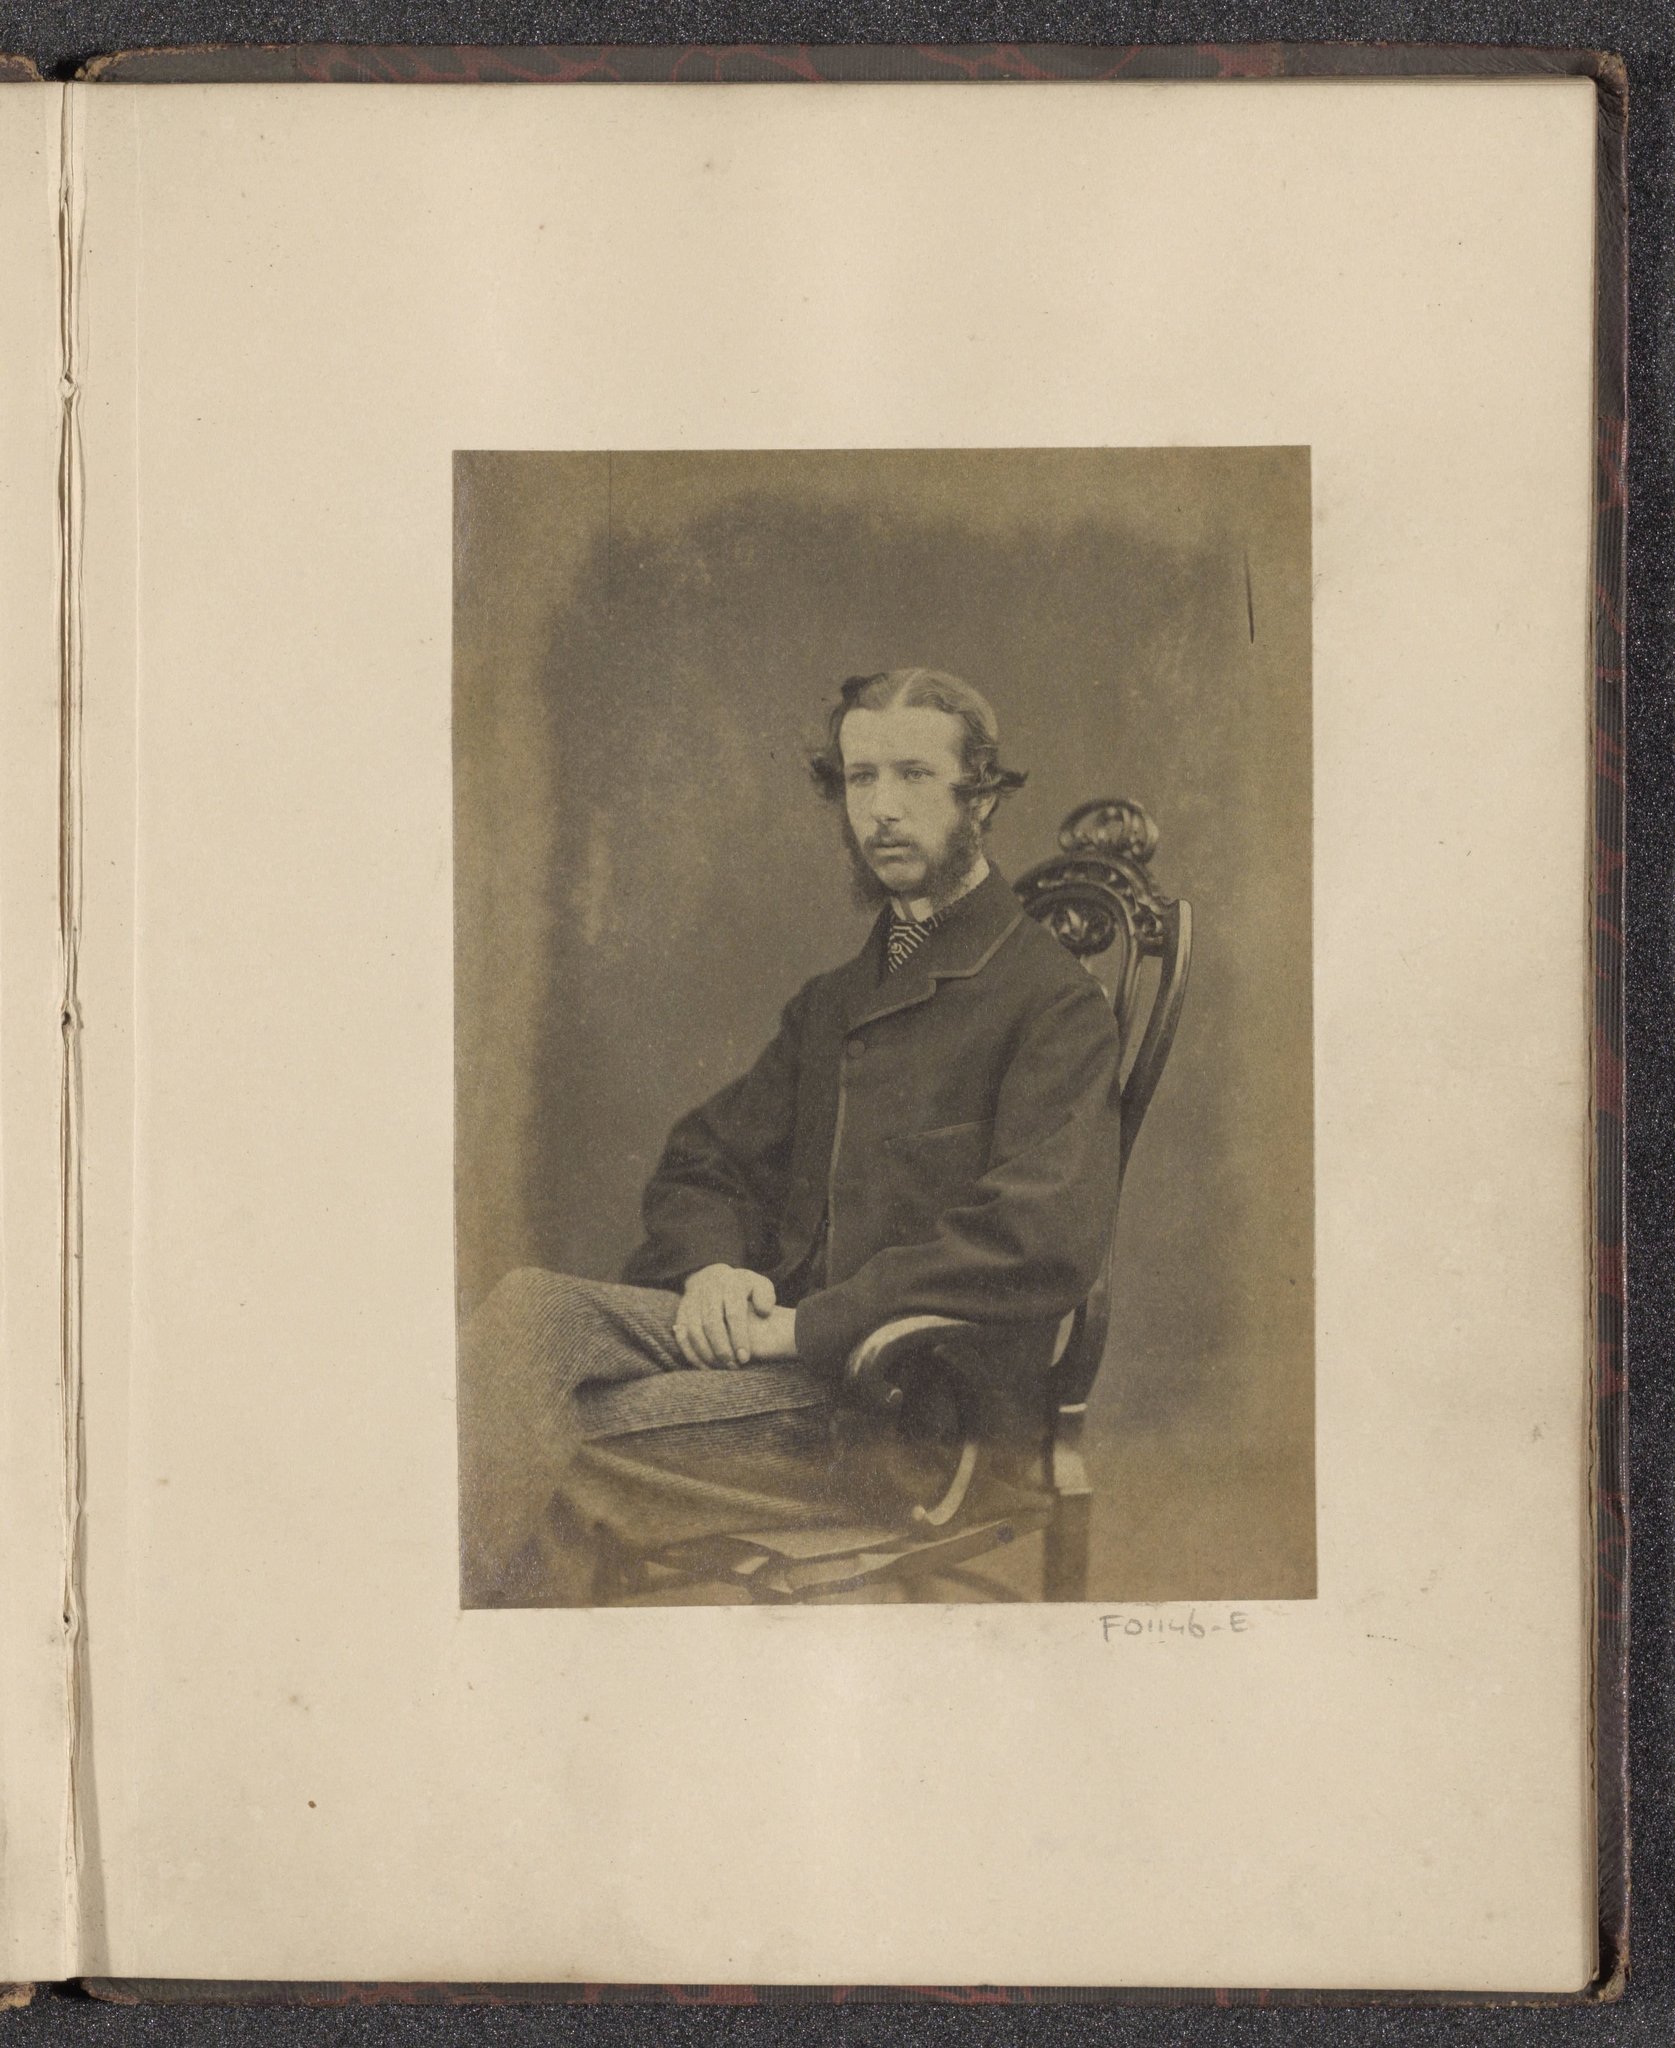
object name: photograph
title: Portret van een student met bakkebaarden in Oxford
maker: j. bagnall evans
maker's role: fotograaf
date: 1860-1861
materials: paper, photographic support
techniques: albumen print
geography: oxford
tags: sideburns, trousers, breeches, higher education, e.g.: teacher's college (+ pupil), university education, youth, adolescent, neck-gear ~ clothing, chair, student, coat, cape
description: Onderdeel van Fotoalbum met 6 portretten van studenten van het Jesus College in Oxford.